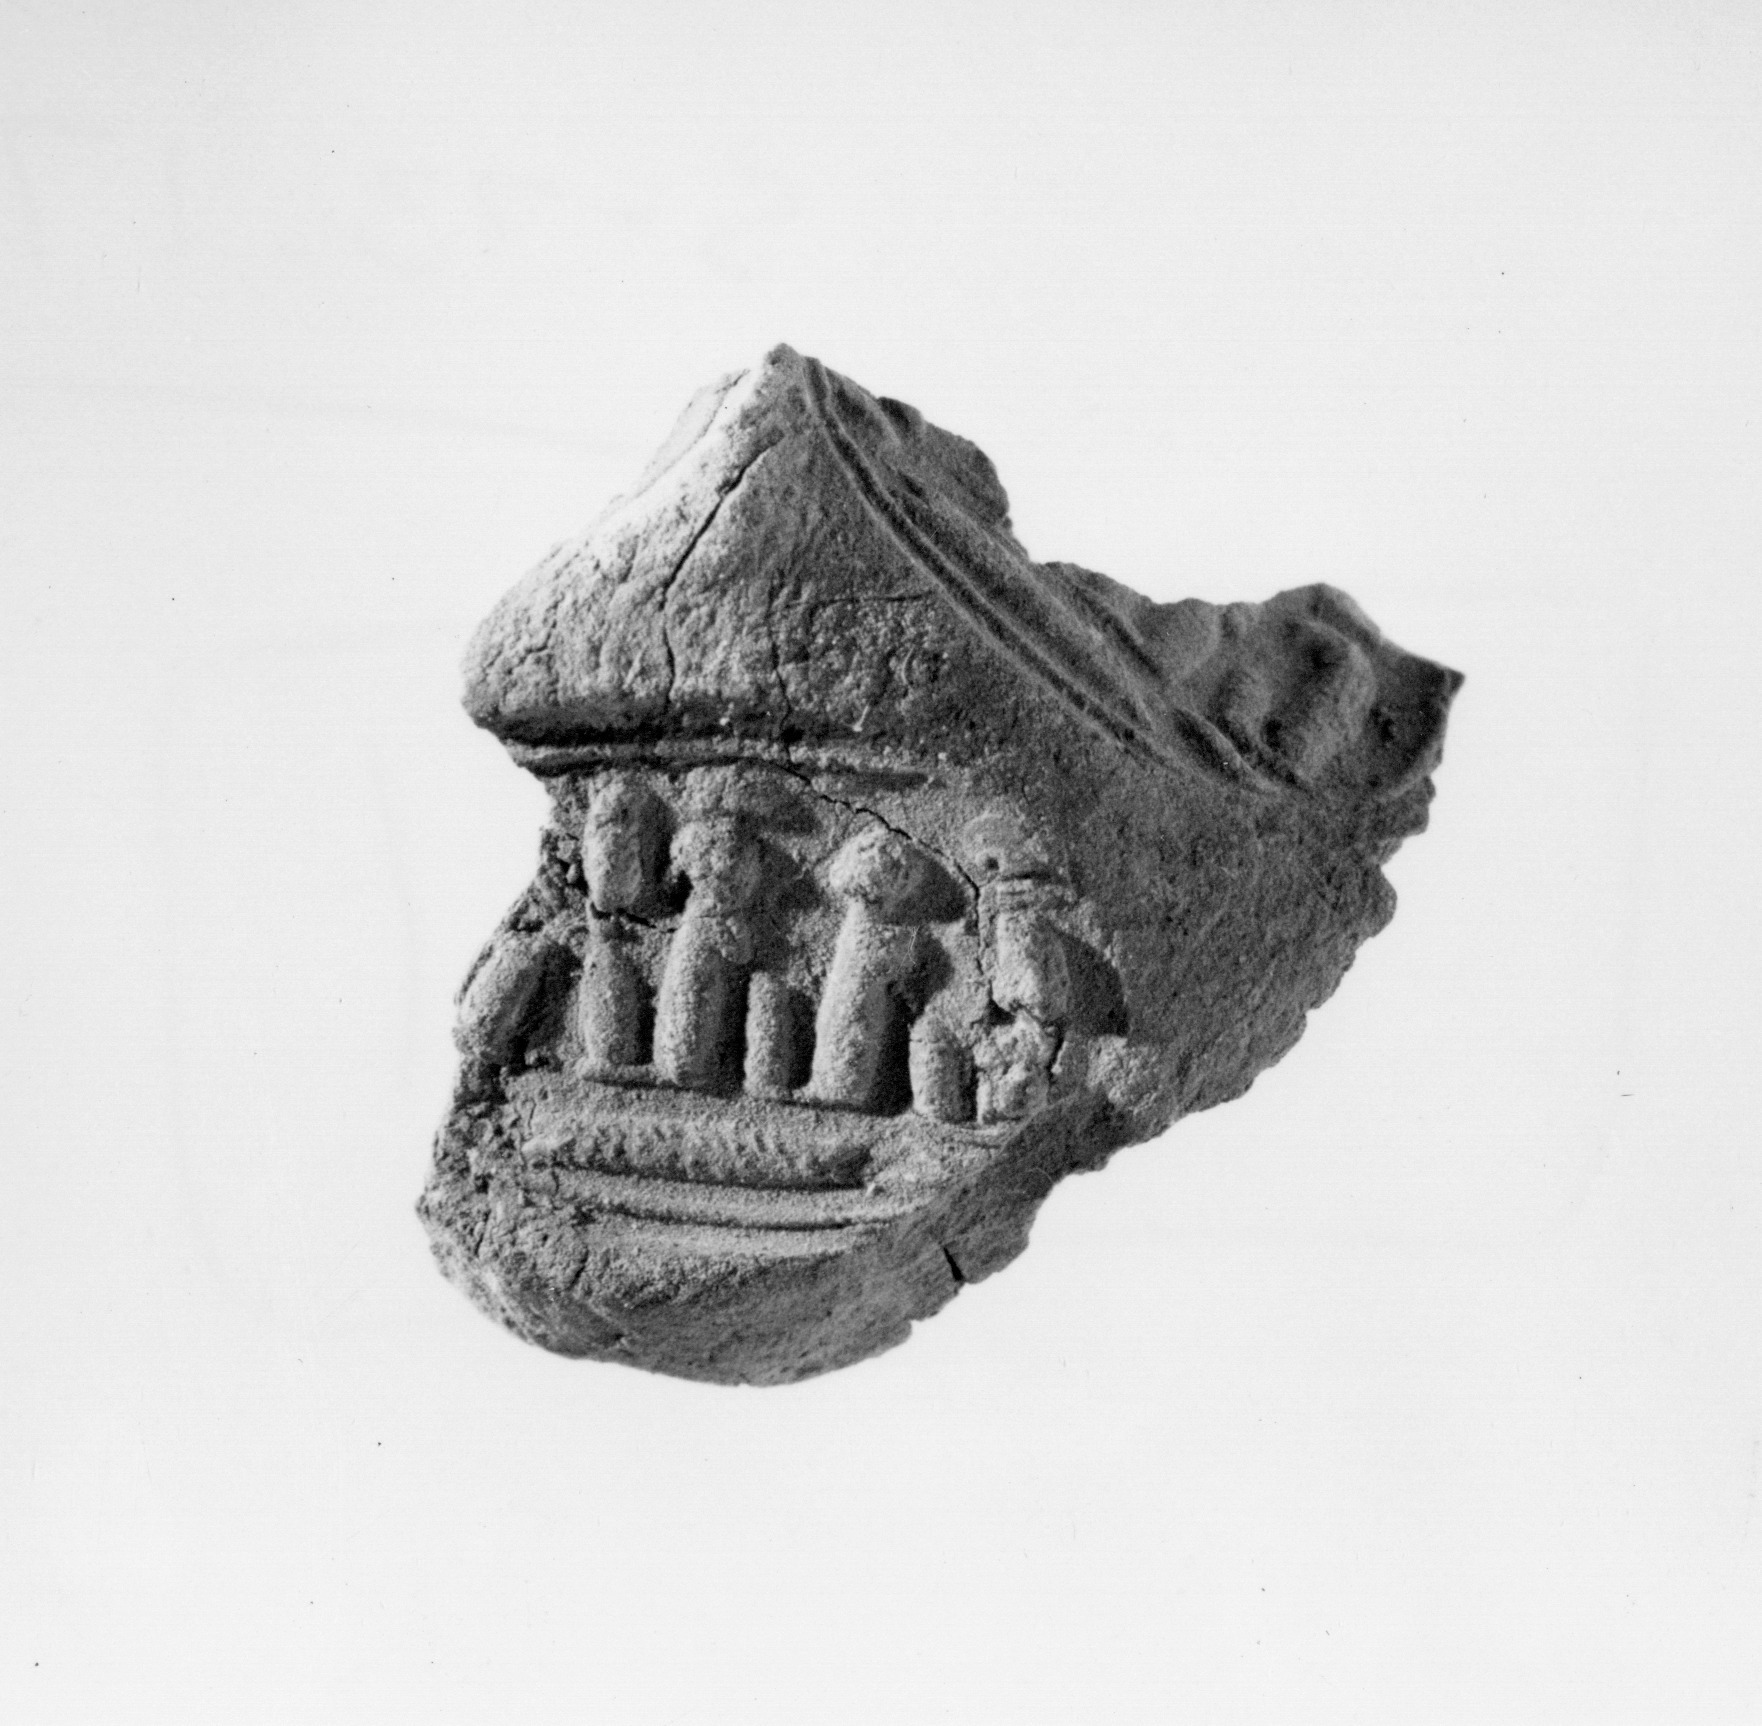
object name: sealing, nebmaatre, amenhotep iii, thoth, ptah, re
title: Document Sealing With the Throne Name of Amenhotep III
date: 1390-1352 BCE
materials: mud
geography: egypt